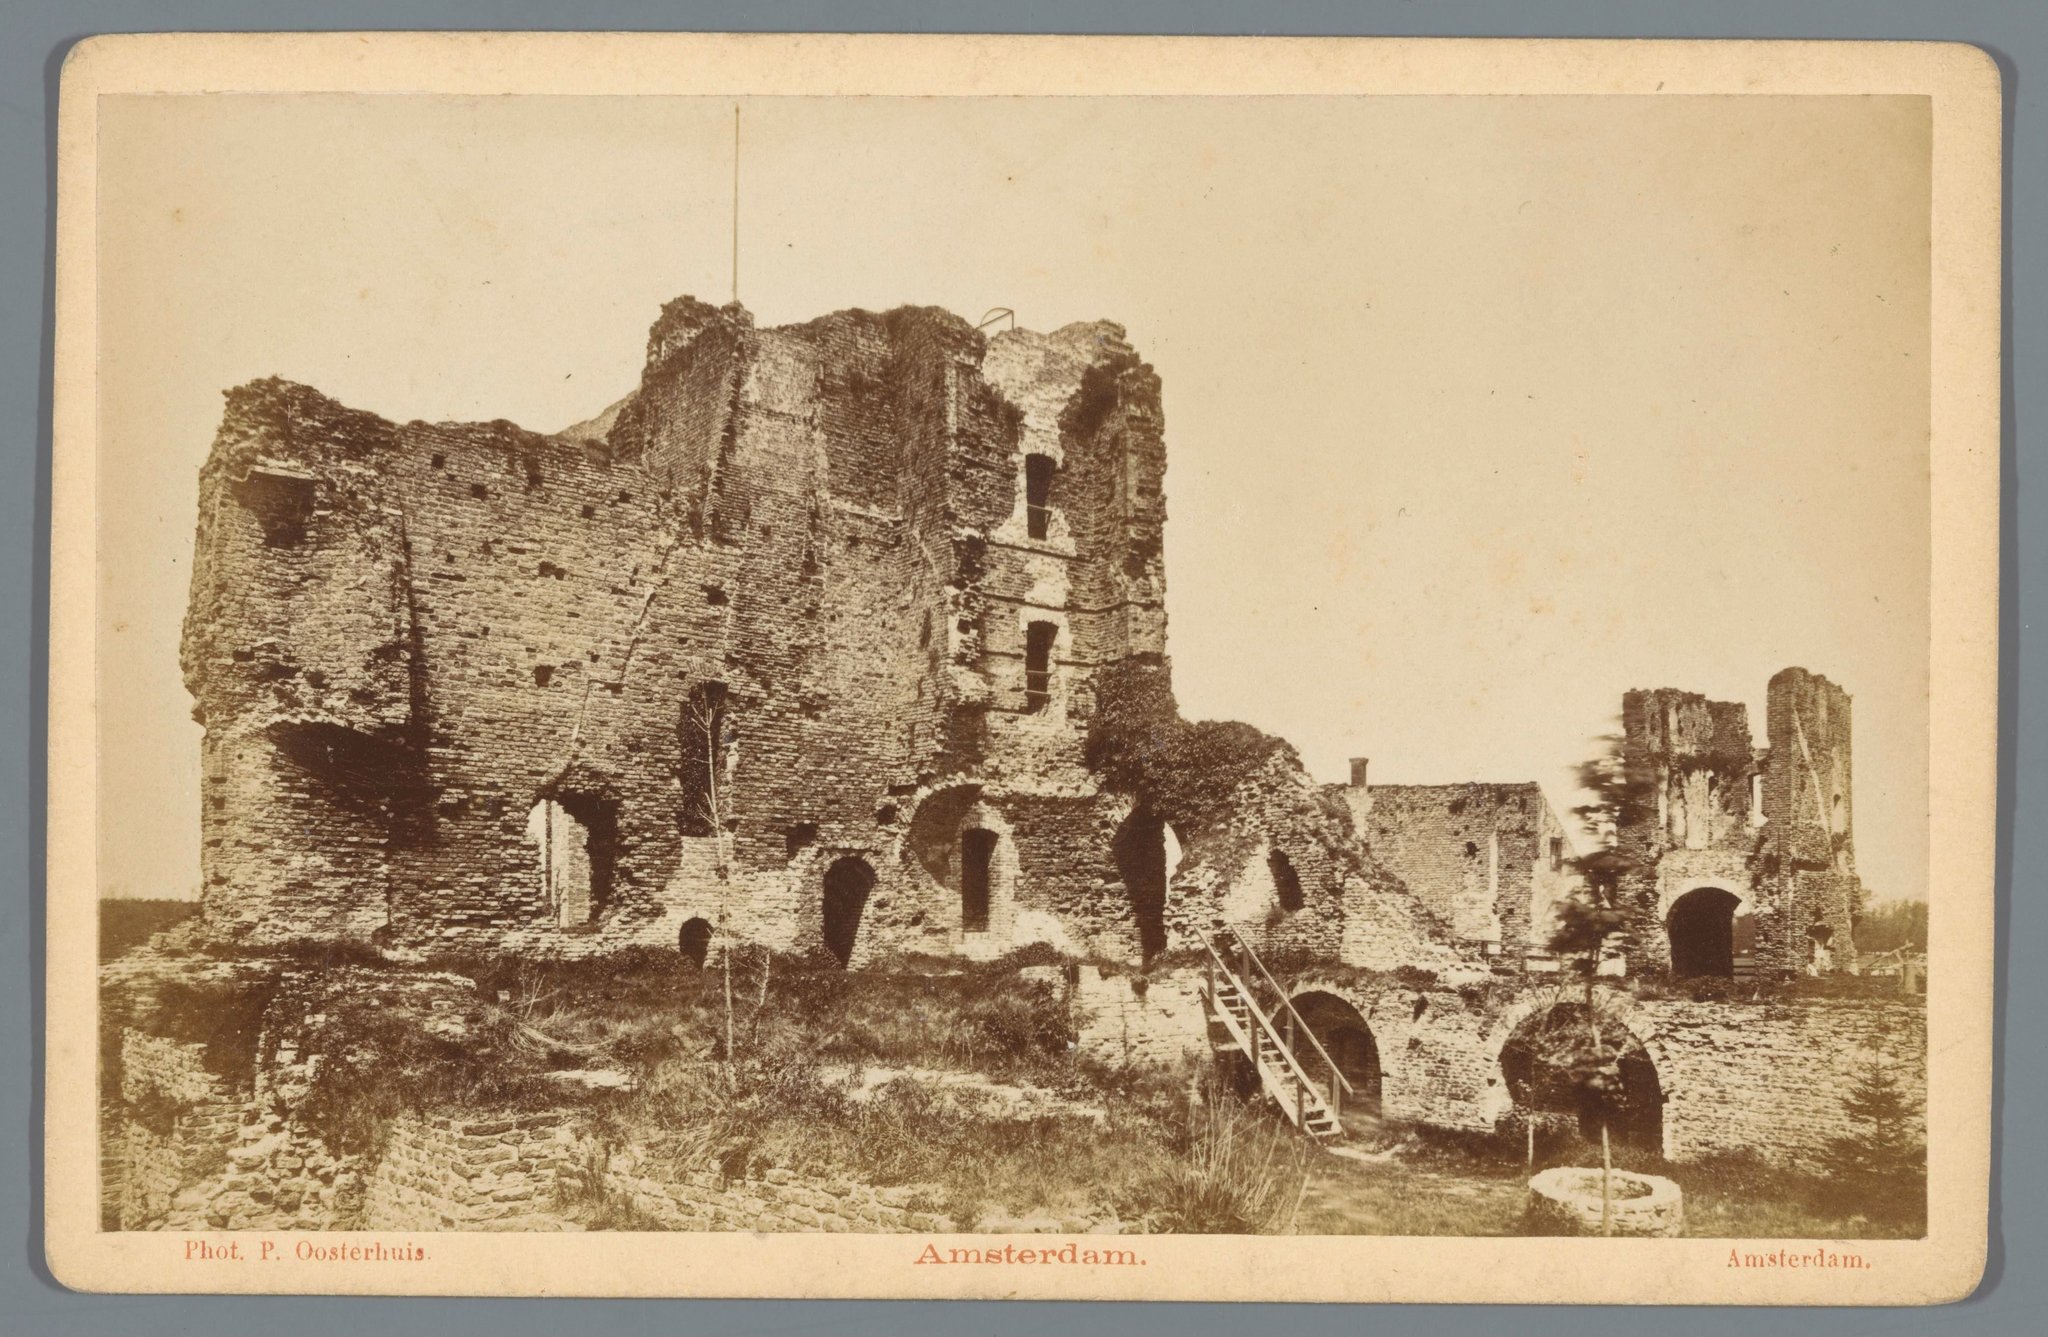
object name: cabinet photograph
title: Ruïne van Brederode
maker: pieter oosterhuis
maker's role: draughtsman, print maker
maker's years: 1816-1885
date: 1867-1883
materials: cardboard, paper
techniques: albumen print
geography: santpoort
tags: ruin of a building ~ architecture, ruin of a dwelling, house, castle, etc.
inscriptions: inscription: ‘Phot. P. Oosterhuis./ Amsterdam./ Amsterdam.’, watermark